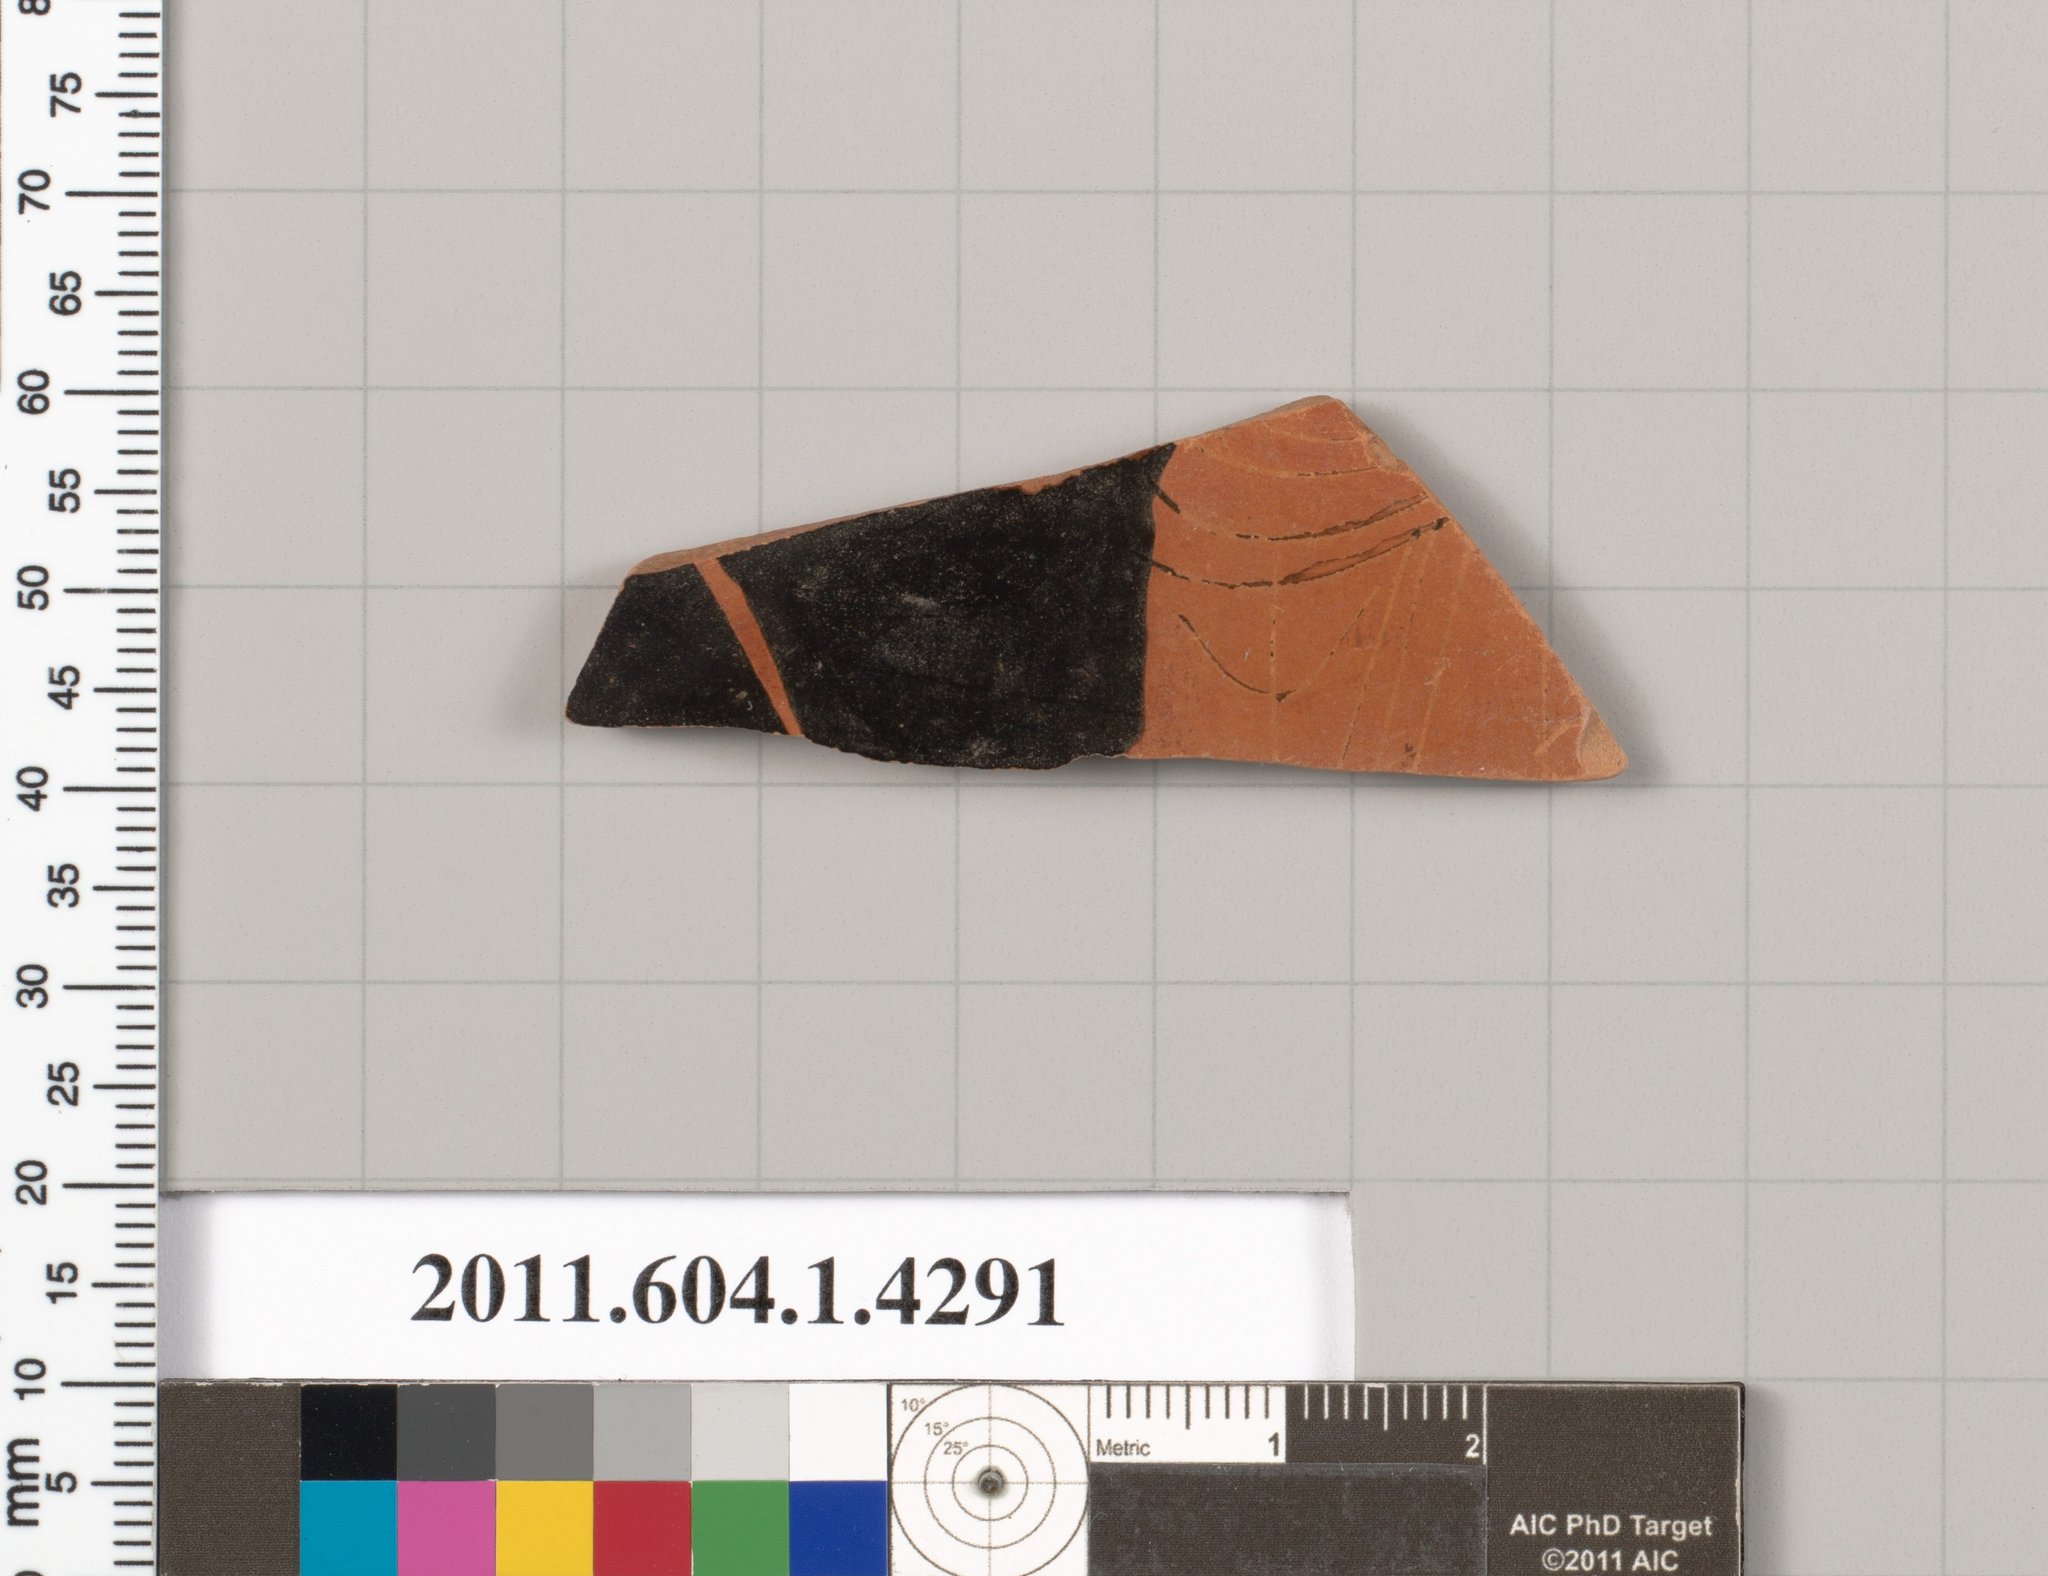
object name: kylix fragment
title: Terracotta fragment of a kylix (drinking cup)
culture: greek, attic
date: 475-451 BCE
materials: terracotta